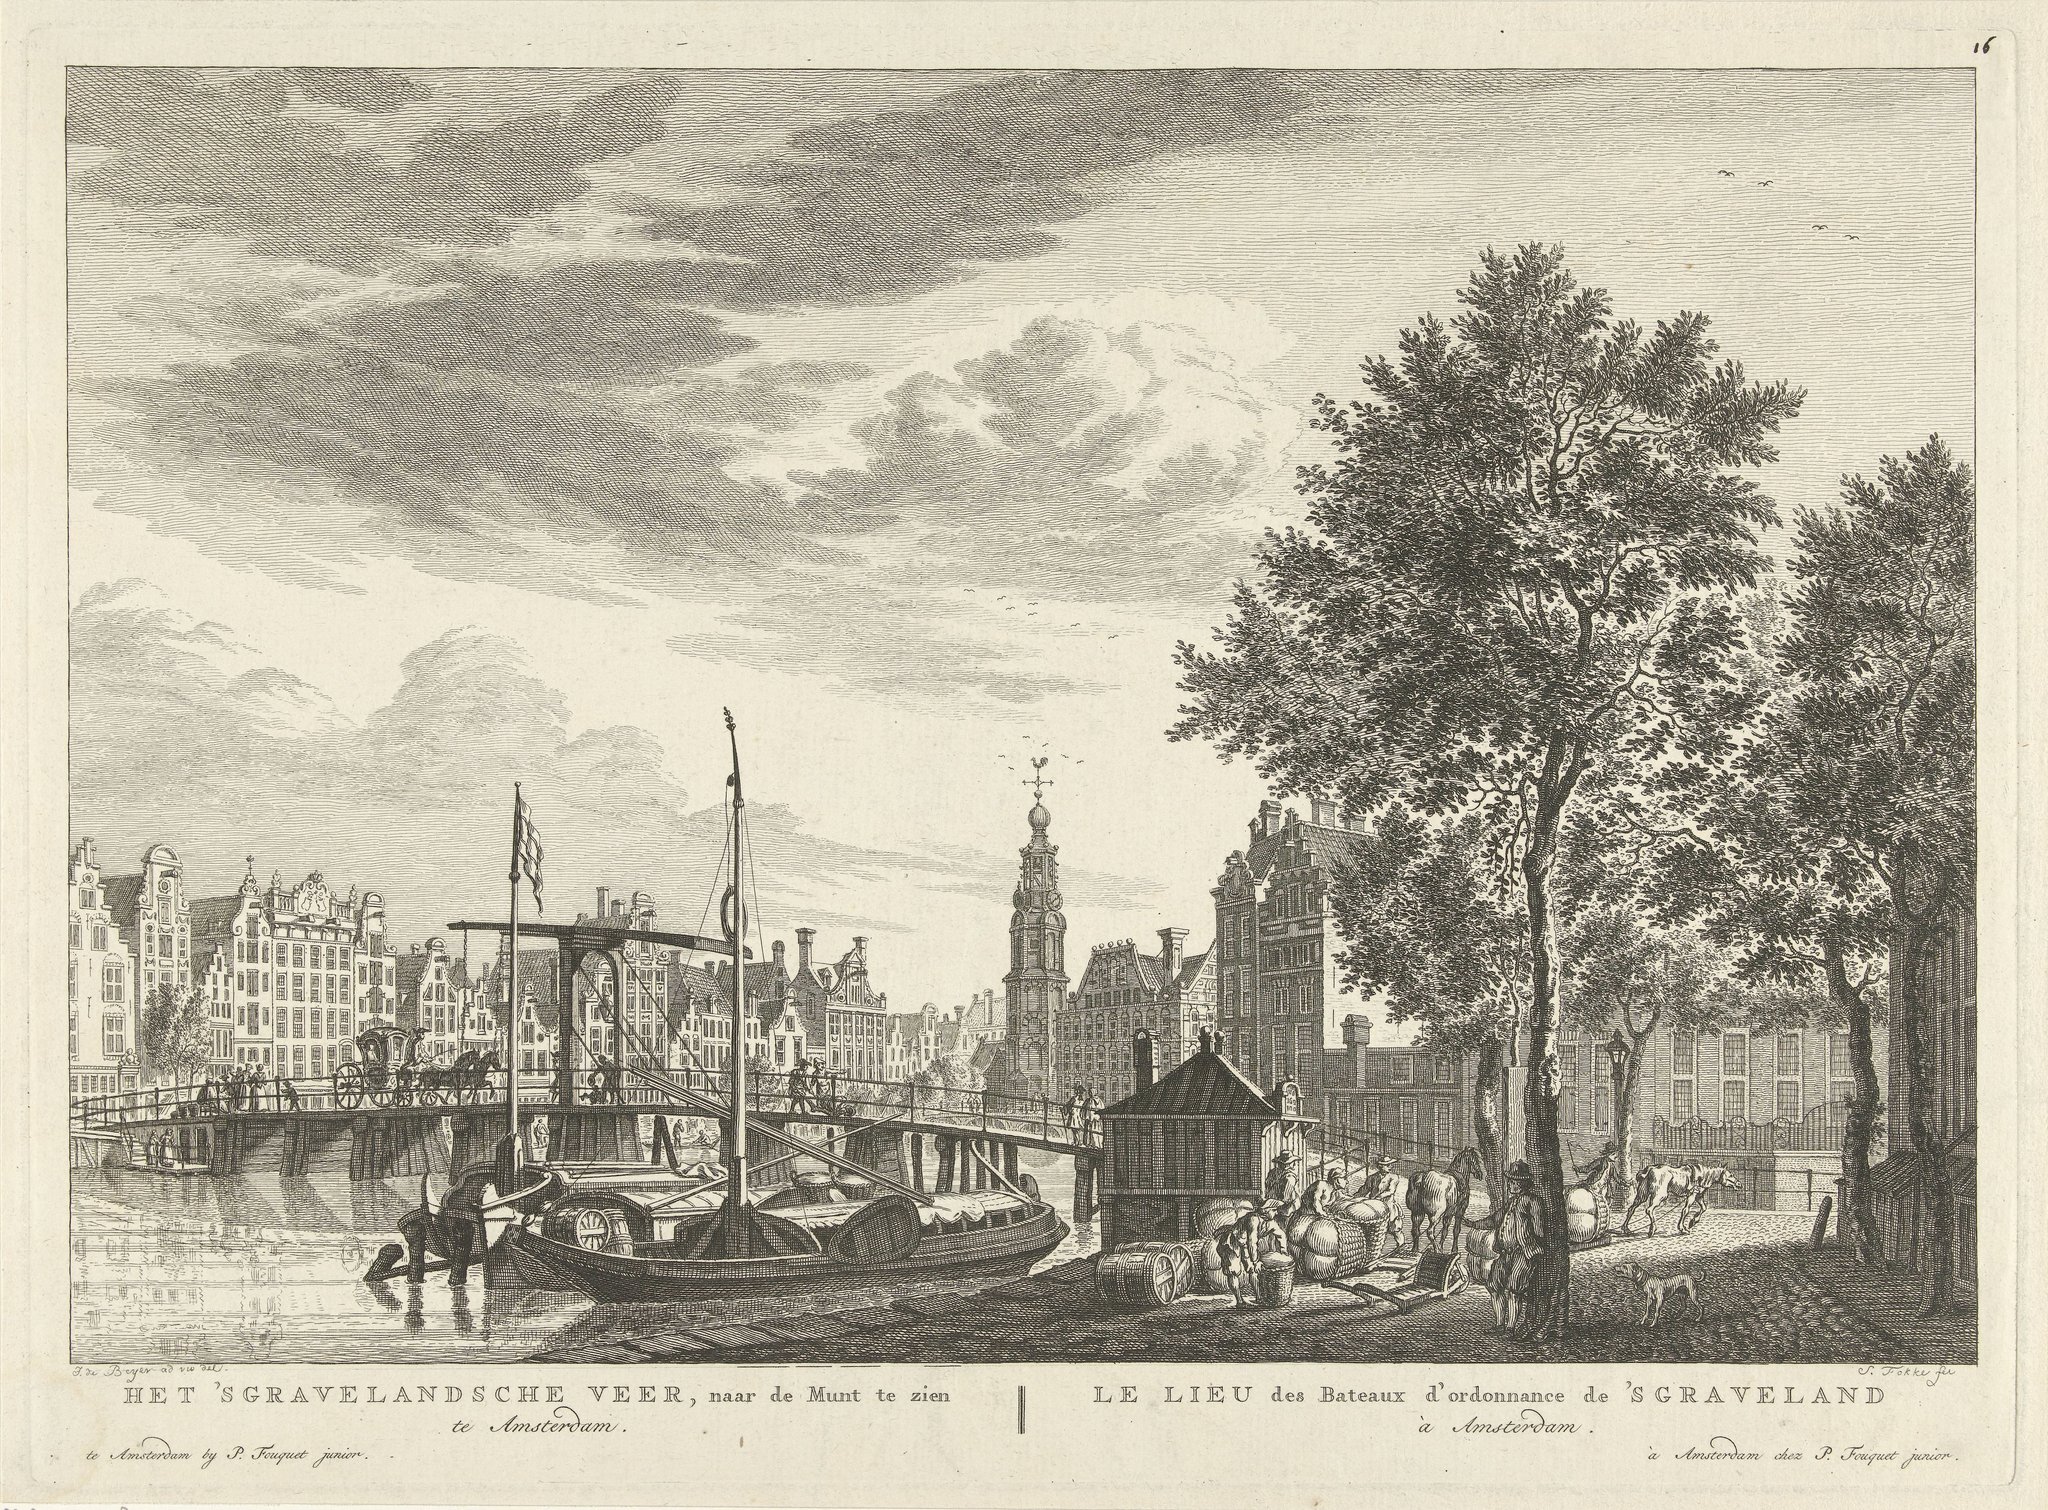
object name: print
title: Gezicht op de Munttoren te Amsterdam, gezien vanaf het 's-Gravelandseveer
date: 1760-1783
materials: ink, paper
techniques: engraving, etching, pen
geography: amsterdam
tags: bridge in city across river, canal, etc. (+ city(-scape) with figures, staffage), tower, clock tower ~ monumental adornment, ferry, canals, waters (in city) (+ city(-scape) with figures, staffage), street (+ city(-scape) with figures, staffage)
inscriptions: inscription: ‘16’, collector's mark: Lugt 2233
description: Deze prent is ook gebruikt in de zogenaamde Atlas van Fouquet.* Pierre Fouquet gaf vanaf 1760 stadsgezichten van Amsterdam - naar tekeningen van verschillende kunstenaars, gemaakt door verschillende prentmakers - uit. Deze prenten werden aanvankelijk los of in series verkocht. Zoals toen gebruikelijk kon de koper de prenten zelf laten inbinden. Hiertoe gaf Fouquet tussen 1778 en 1783 een titelblad, plattegrond en inhoudsopgave van de tot dusver 100 uitgegeven prenten uit (1). Gezien de inhoud afhankelijk was van wat de koper had verzameld verschilt de inhoud van de verschillende bewaarde Fouquetatlassen onder deze titel sterk. Ook zijn er exemplaren bekend waar tevens andere prenten aan zijn toegevoegd. Omdat er behoefte bleek aan uitleg bij de platen werd in 1783 een nieuwe versie van de atlas uitgegeven, aangevuld met tekst en twee prenten. De aangegeven volgorde veranderde maar de platen van de al eerder uitgegeven prenten bleven ongewijzigd. Deze uitgave werd in opdracht van Fouquet gedrukt bij Daniël Jean Changuion en Petrus den Hengst (2). Een tiental platen werd bijgewerkt en verscheen, met nieuw impressum, in het vervolg van Wagenaars geschiedenis van Amsterdam, uitgeven door Petrus Conradi en Folkert van der Plaats (3). Een aantal jaar na het overlijden van Fouquet kwam Evert Maaskamp met een nieuwe uitgave van de atlas, met verbeterde tekst en toevoeging van twee prenten. Op alle platen verwijderde hij het oude en liet hij zijn eigen impressum zetten (4). De huidige staat van de prent komt voor in exemplaren van de onder (1) en (2) genoemde werken. * Onder de Atlas van Fouquet of Fouquetatlas verstaan we de hieronder vermelde publicaties (1), (2) en (4). (1). Afbeeldingen van de wyd-vermaarde koopstad Amsterdam benevens des zelvs voornaamste gebouwen en gezigten alle naar het leeven getekend / Receuil des edifices les plus considerables et des plus belles vues, de la fameuse ville d'Amsterdam, dessinées d'après nature. Amsterdam: Pierre Fouquet, 1778-1783. (2). Nieuwe atlas, van de voornaamste gebouwen en gezigten der stad Amsterdam, met derzelver beknopte beschryvingen. 2 delen. Amsterdam: Daniël Jean Changuion en Petrus den Hengst [in opdracht van Pierre Fouquet], 1783. (3). Stijl, Simon. Amsterdam, in zyne geschiedenissen, voorregten, koophandel, gebouwen, kerkenstaat, schoolen, schutterye, gilden en regeeringe, beschreeven. Om te dienen ten vervolge op het werk van Jan Wagenaar (…). 10 delen. Amsterdam en Harlingen: Petrus Conradi en Folkert van der Plaats, 1788-1801. (4). Nieuwe atlas, van de voornaamste gebouwen en gezigten der stad Amsterdam. Met derzelver beknopte beschryvingen. Amsterdam: Evert Maaskamp, 1805. * Het aantal vermelde staten is gebaseerd op het aantal gevonden staten. Mogelijk zijn er meer staten van deze prent. Zie RP-P-1905-396 voor eerste of tweede bekende staat. Zie RP-P-AO-27-30A en RP-P-1905-397 voor vierde bekende staat.